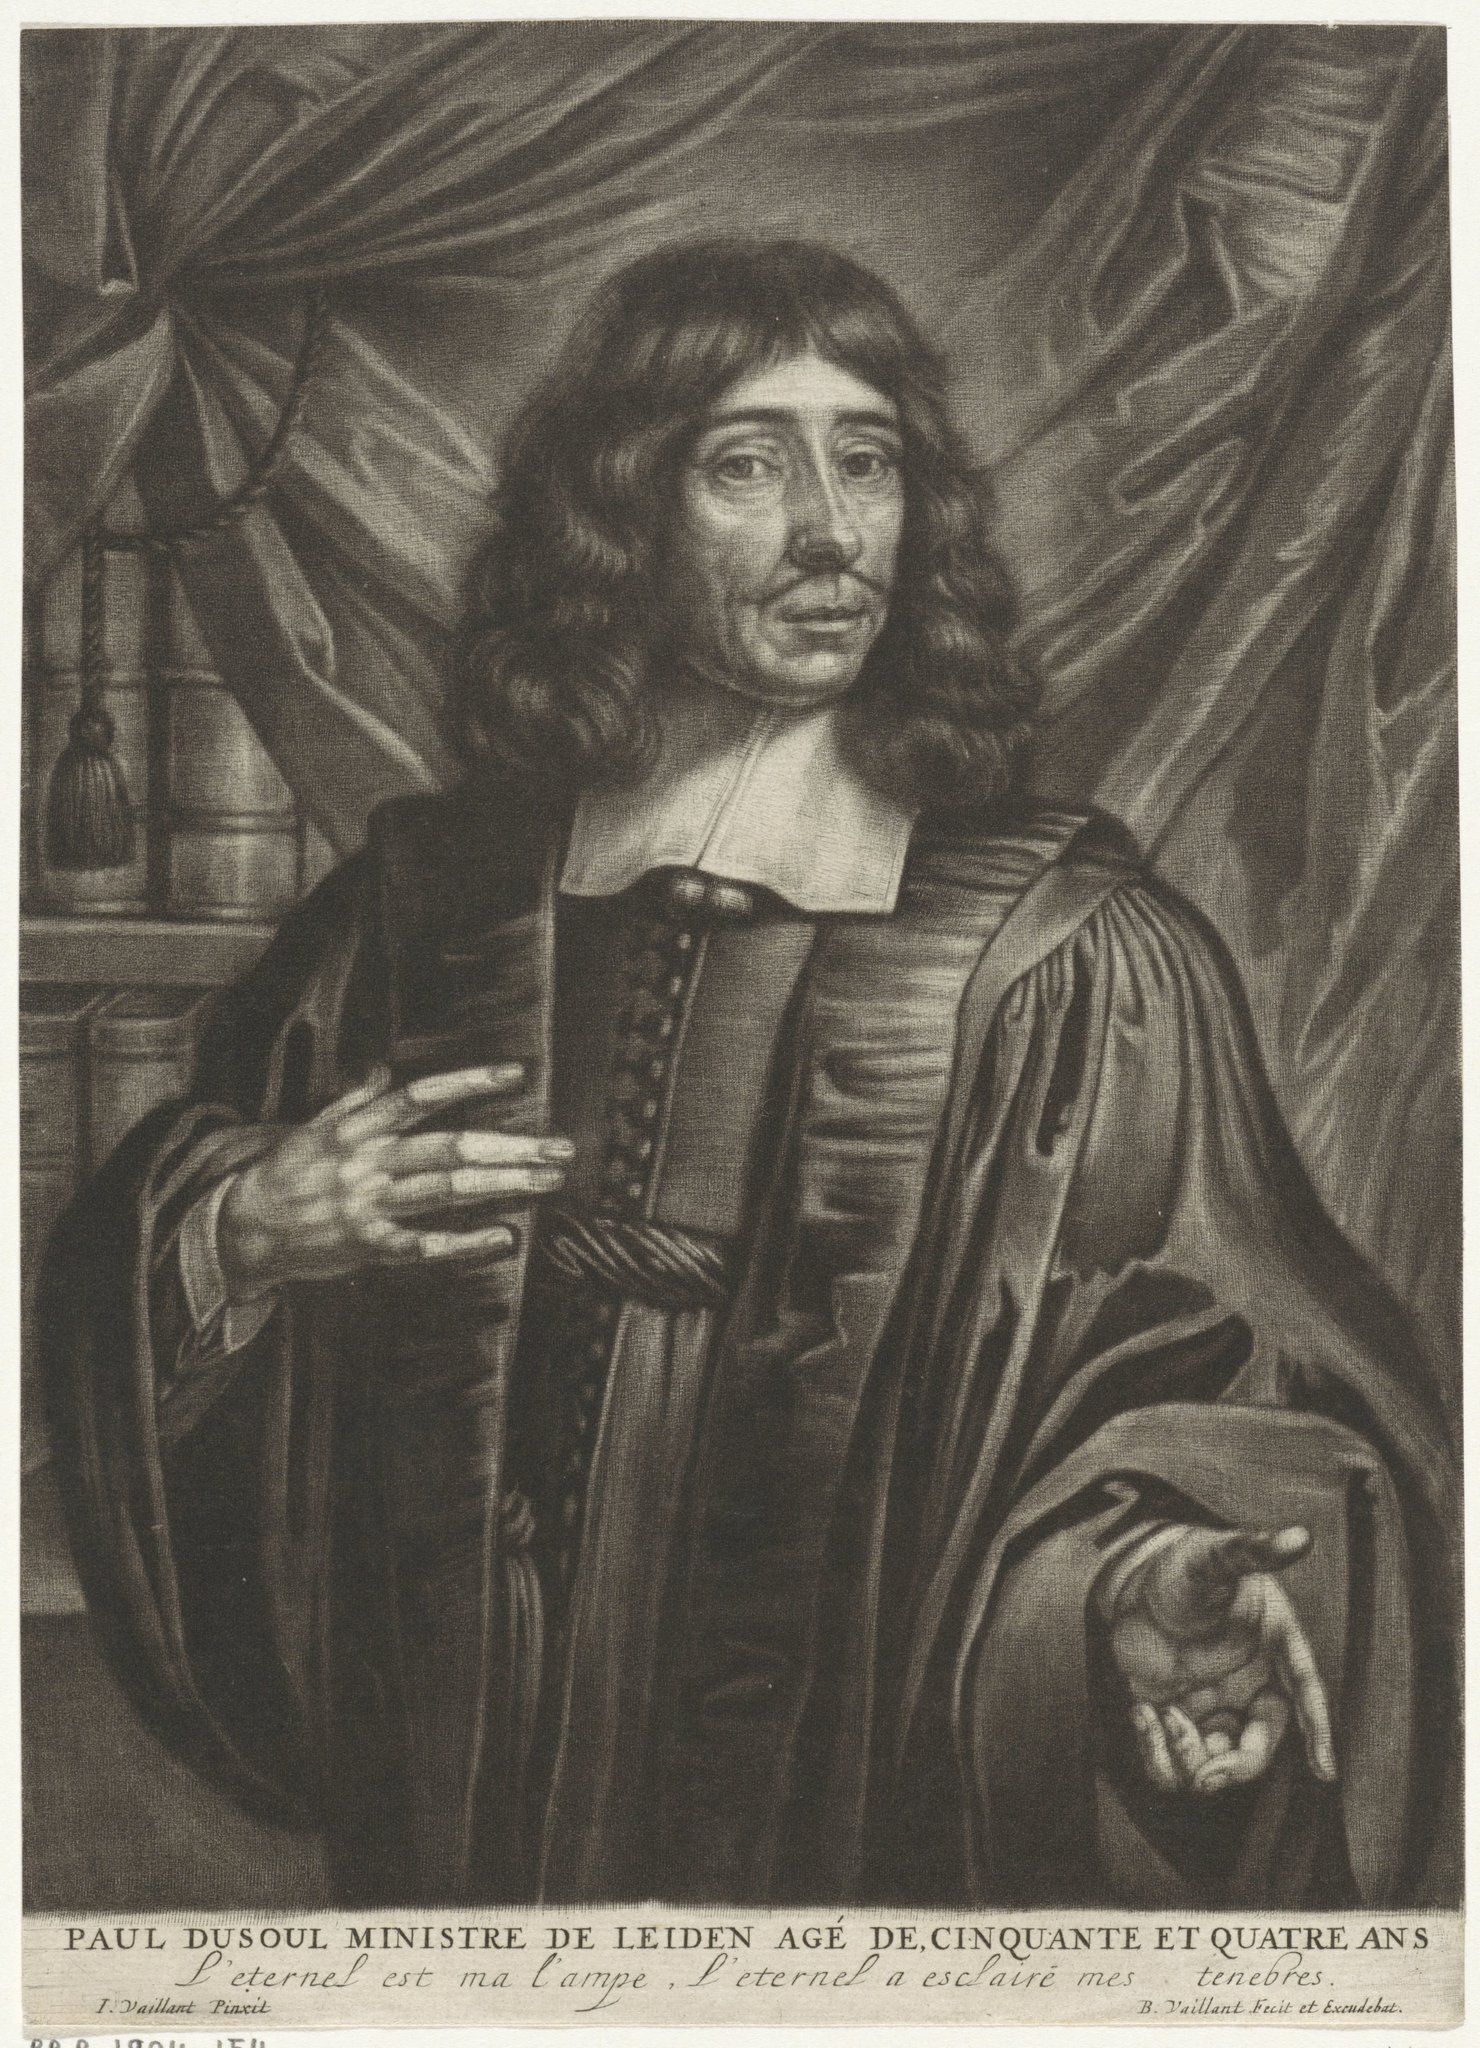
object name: print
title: Portret van Paul Dusoul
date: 1642-1698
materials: paper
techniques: engraving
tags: book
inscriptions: collector's mark: Lugt 2228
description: Paul Dusoul op 54-jarige leeftijd. Hij staat voor een boekenkast en een gordijn.